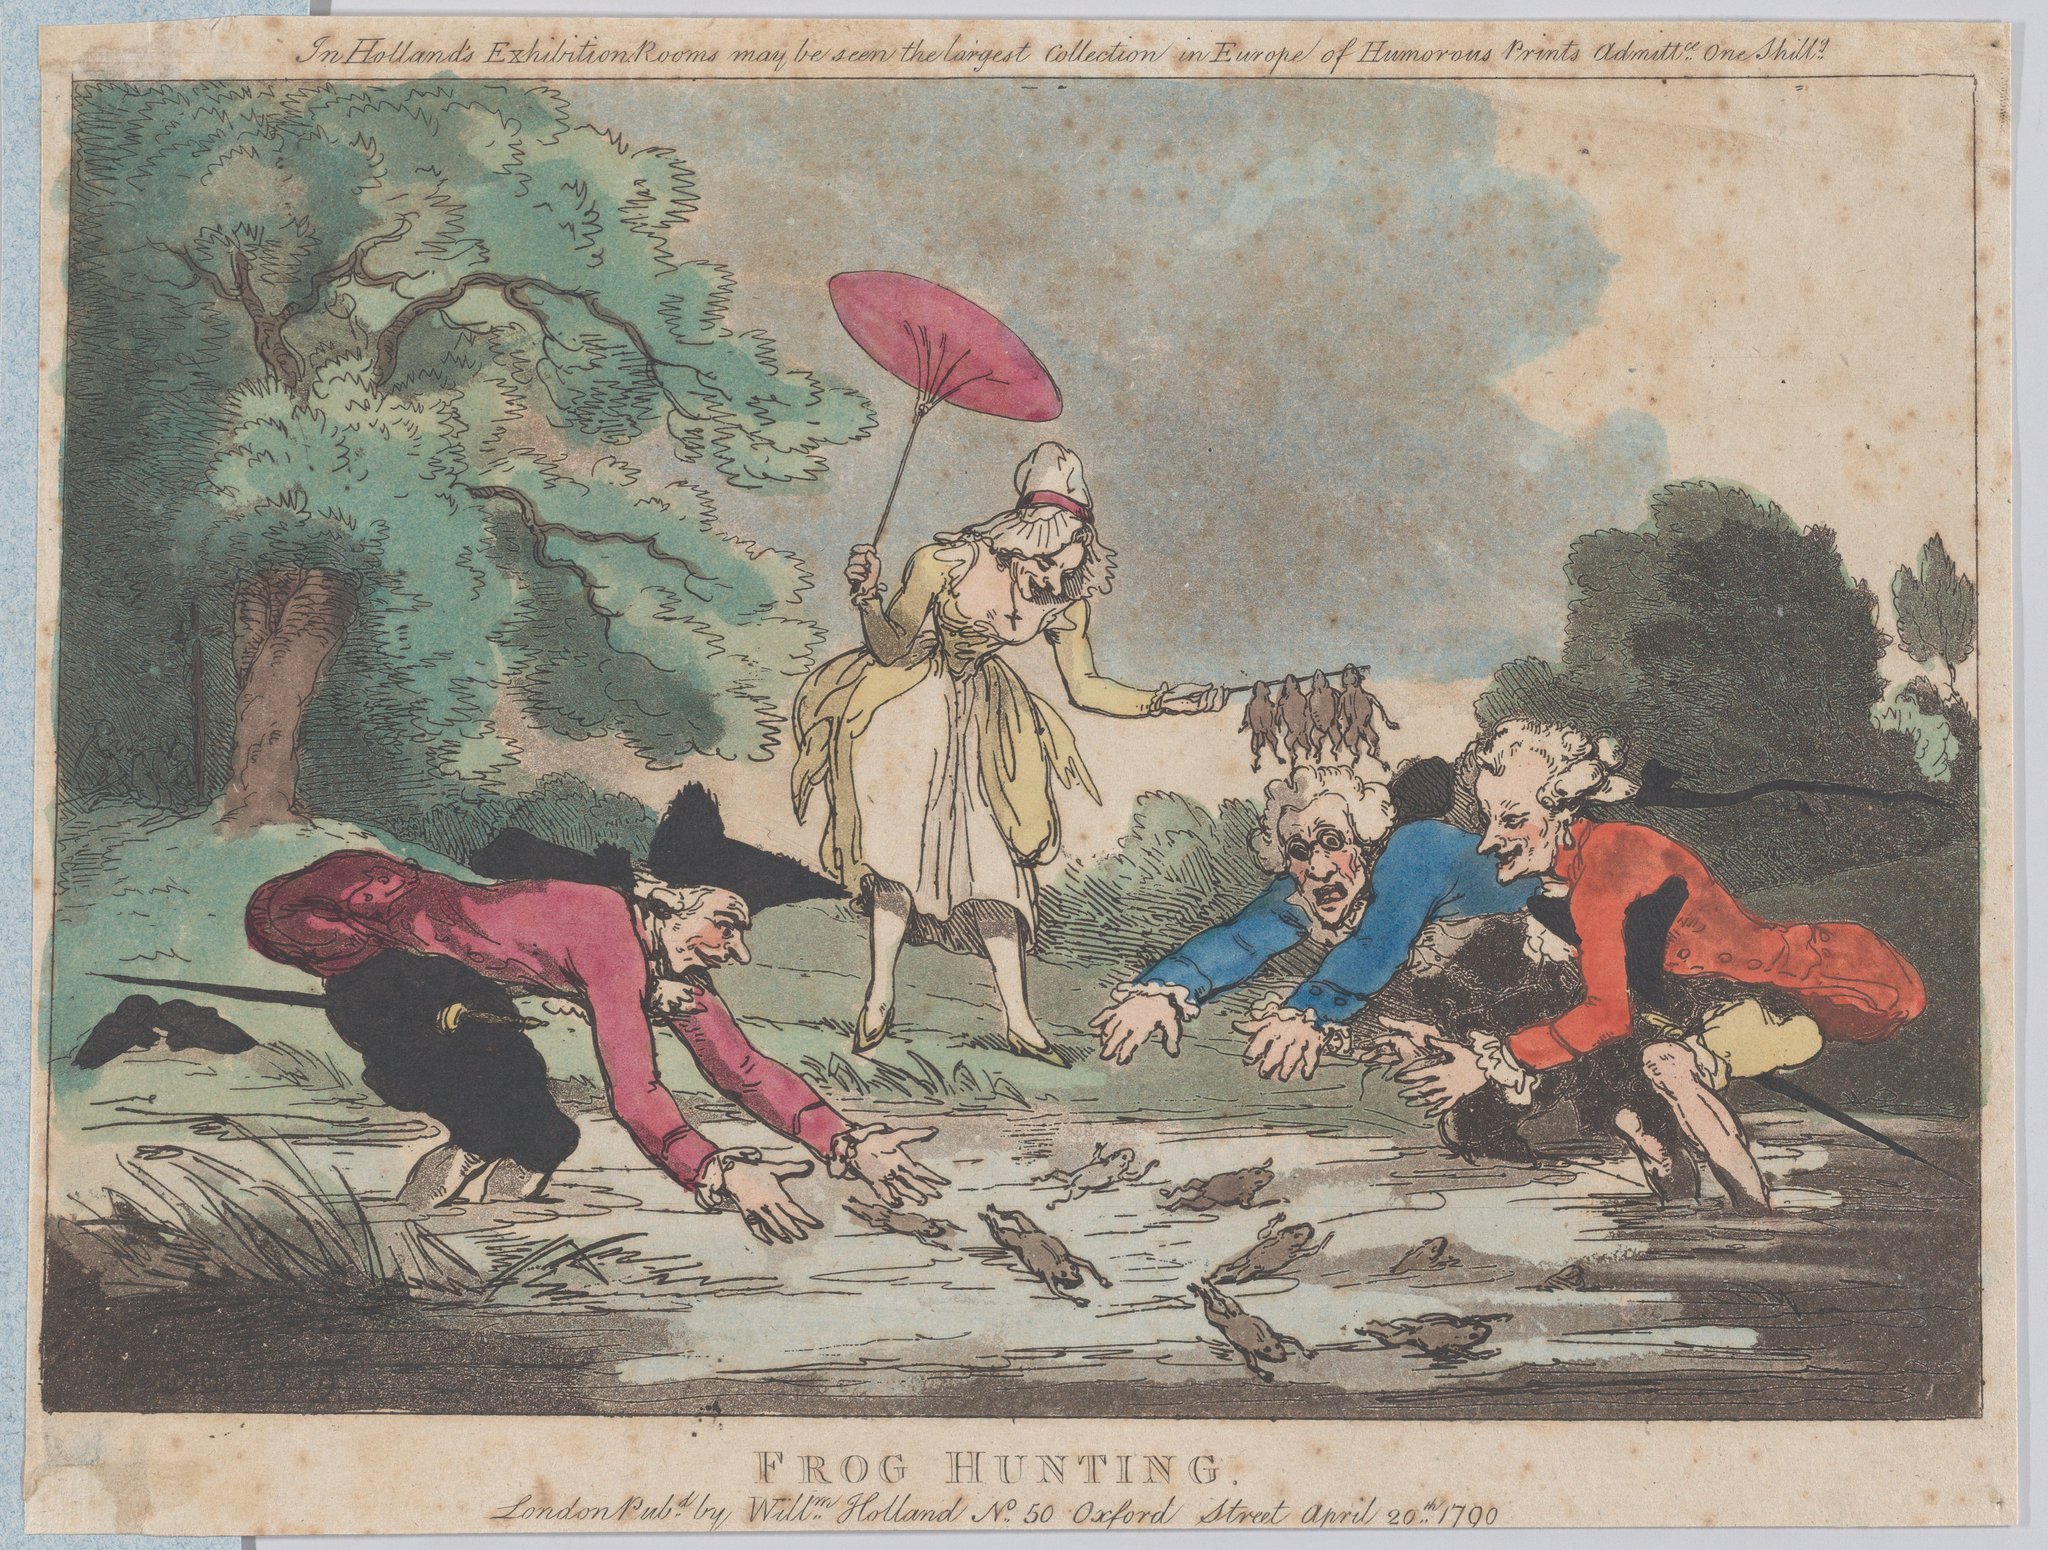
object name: print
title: Frog Hunting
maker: thomas rowlandson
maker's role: artist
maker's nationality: british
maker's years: 1757-1827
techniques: aquatint, etching, hand coloring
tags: satire,men,women,frogs